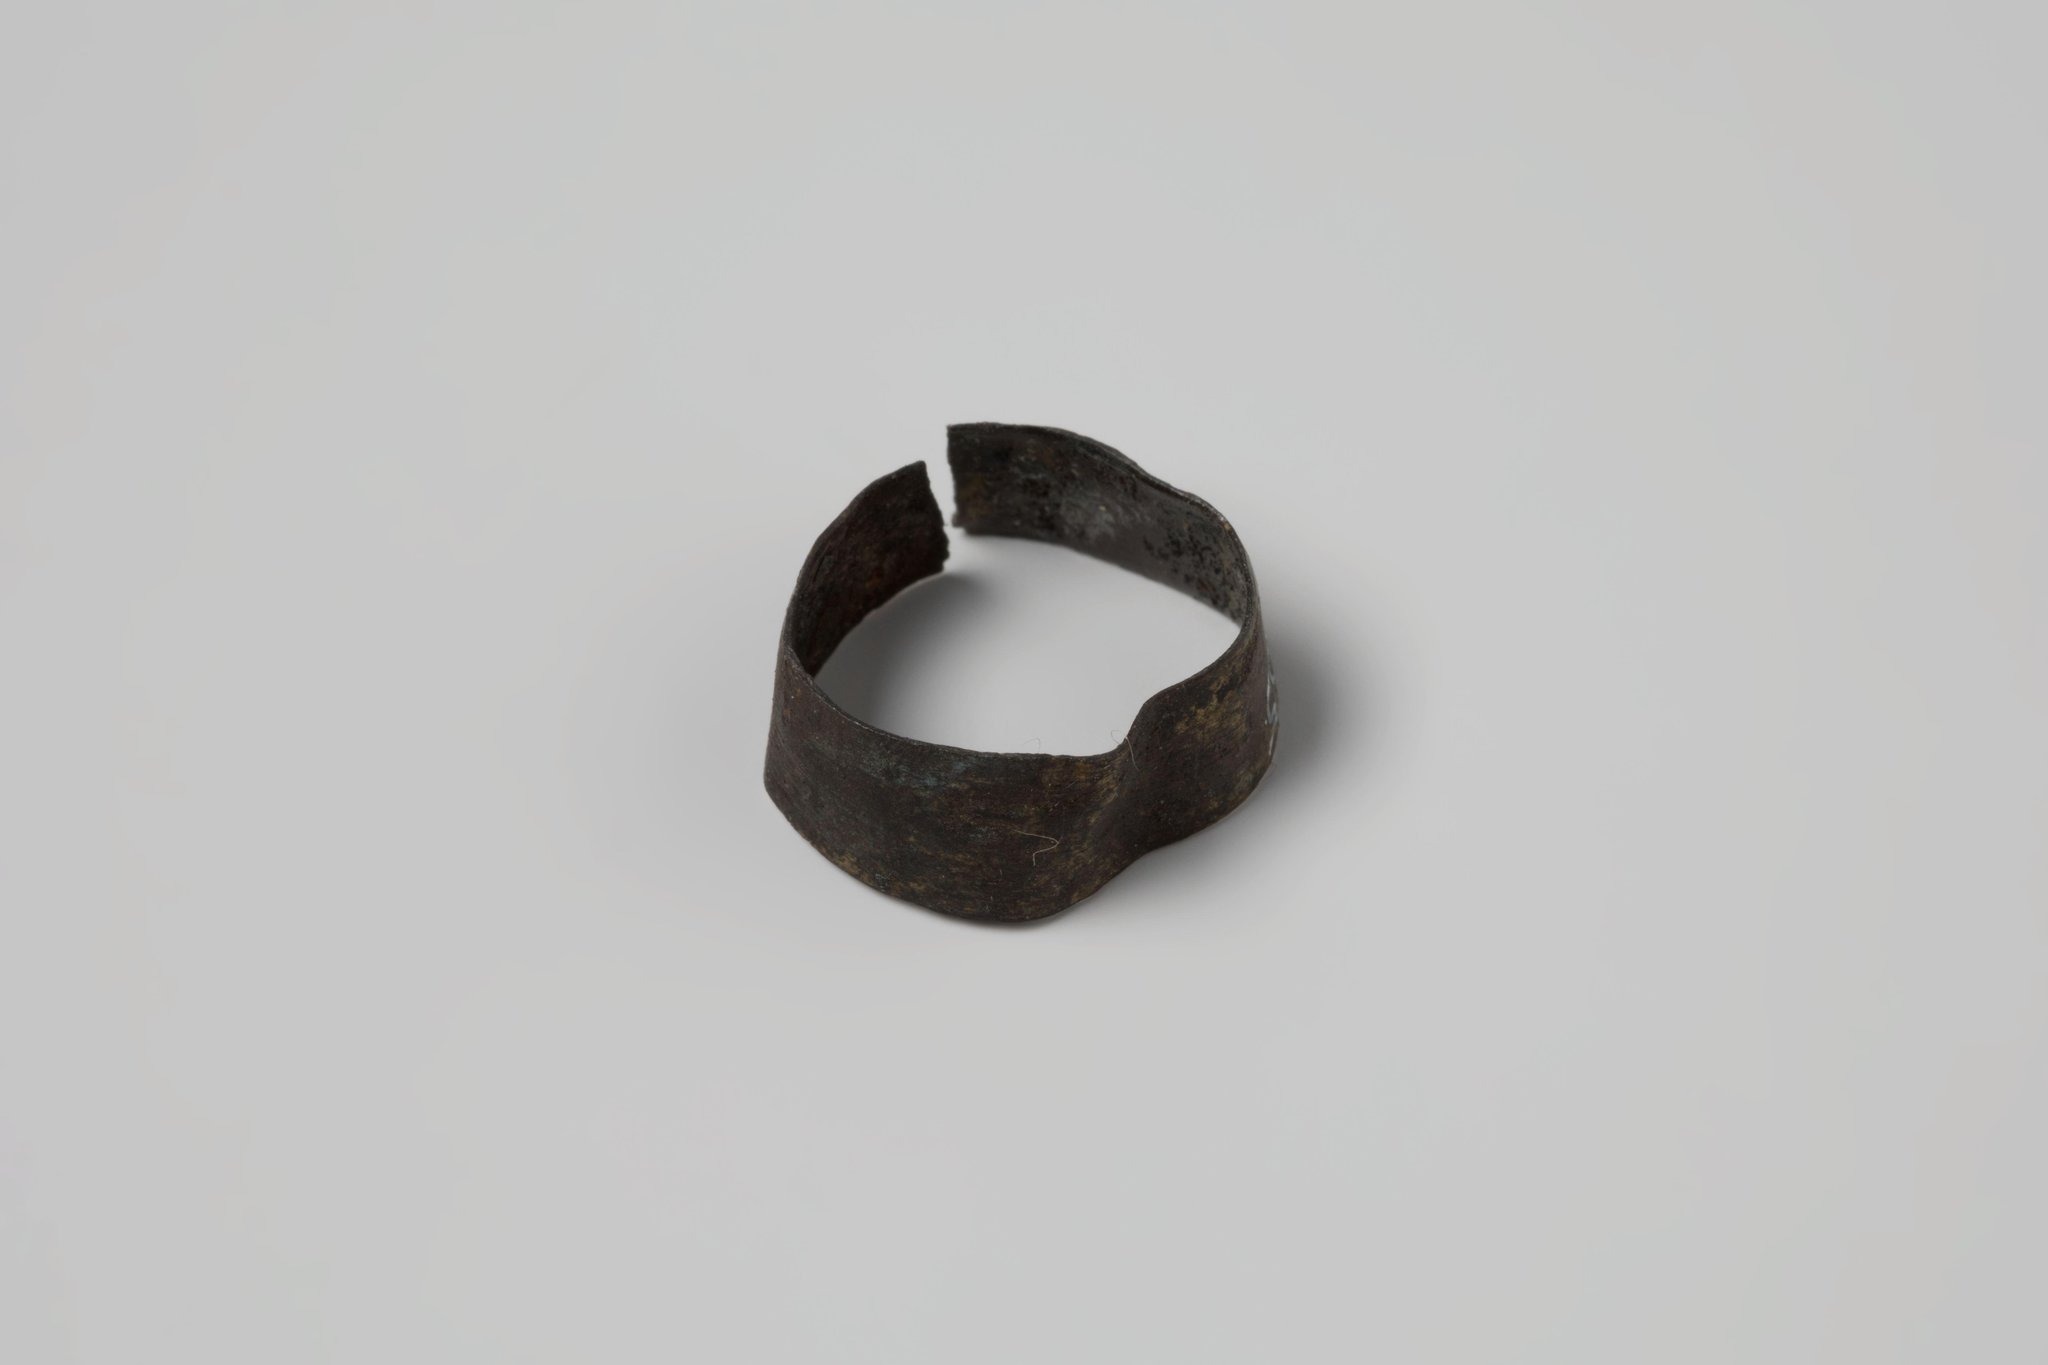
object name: knife handle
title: Messenheftring uit het wrak van de Oost-Indiëvaarder Hollandia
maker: Anonymous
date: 1700-1743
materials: copper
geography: netherlands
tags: verenigde oostindische compagnie, hollandia (schip), annet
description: Knife-handle, ferrule; id. NG 1980-27H426.